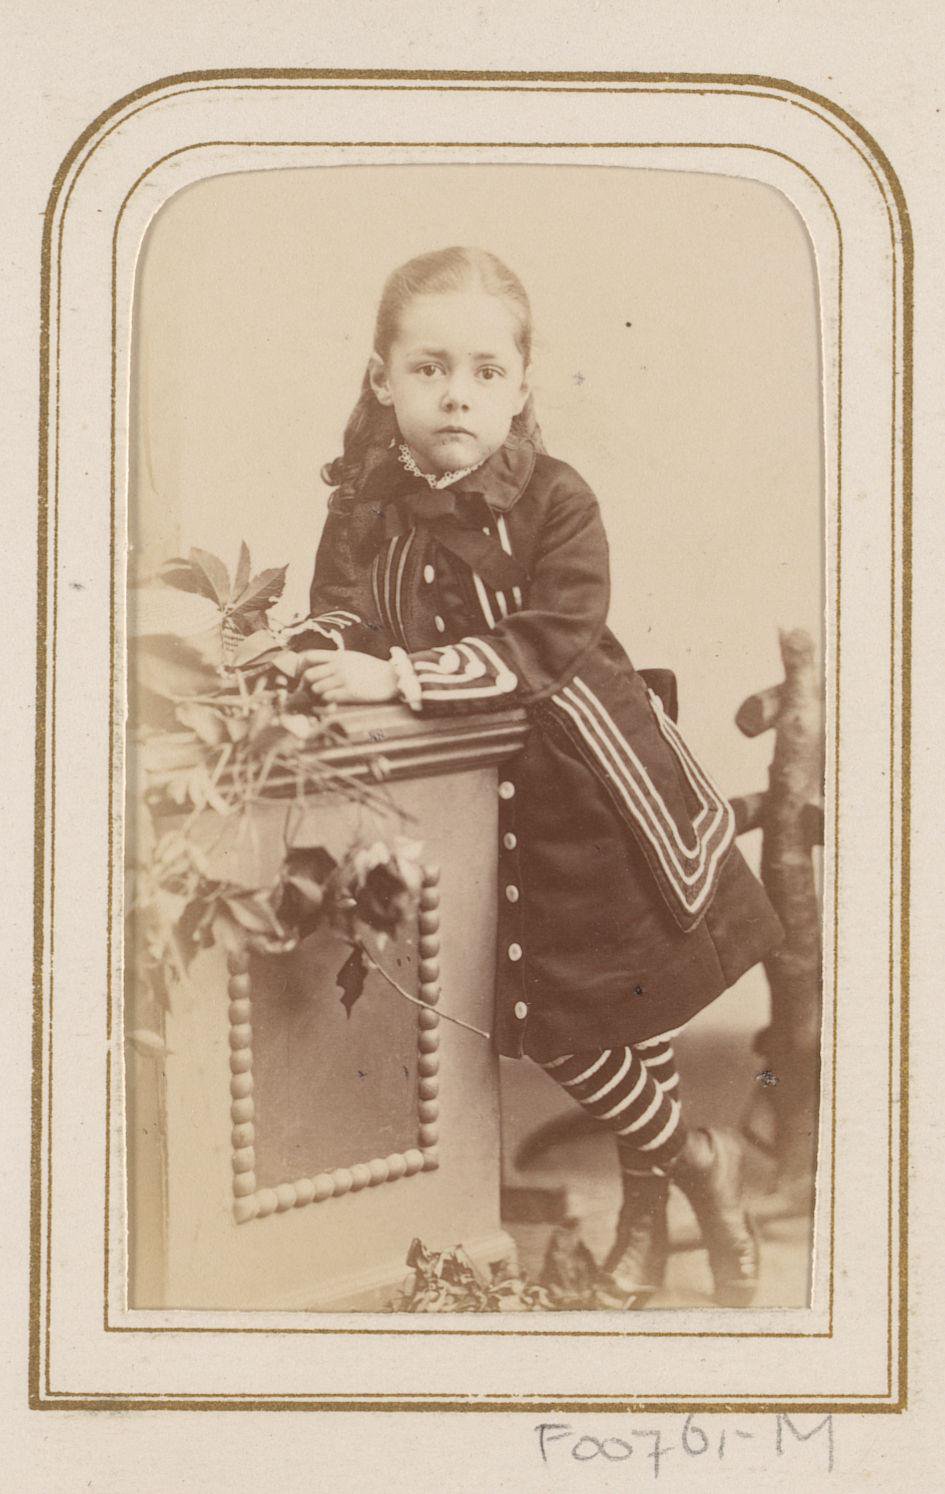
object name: carte de visite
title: Portret van een meisje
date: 1860-1890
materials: cardboard, photographic support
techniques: albumen print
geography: blackheath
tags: girl (child between toddler and youth)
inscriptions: inscription: ‘The Permanent Photography Company, Hyne & Co.,/ 4, Brunswick Place,/ Blackheath Village, S.E.’